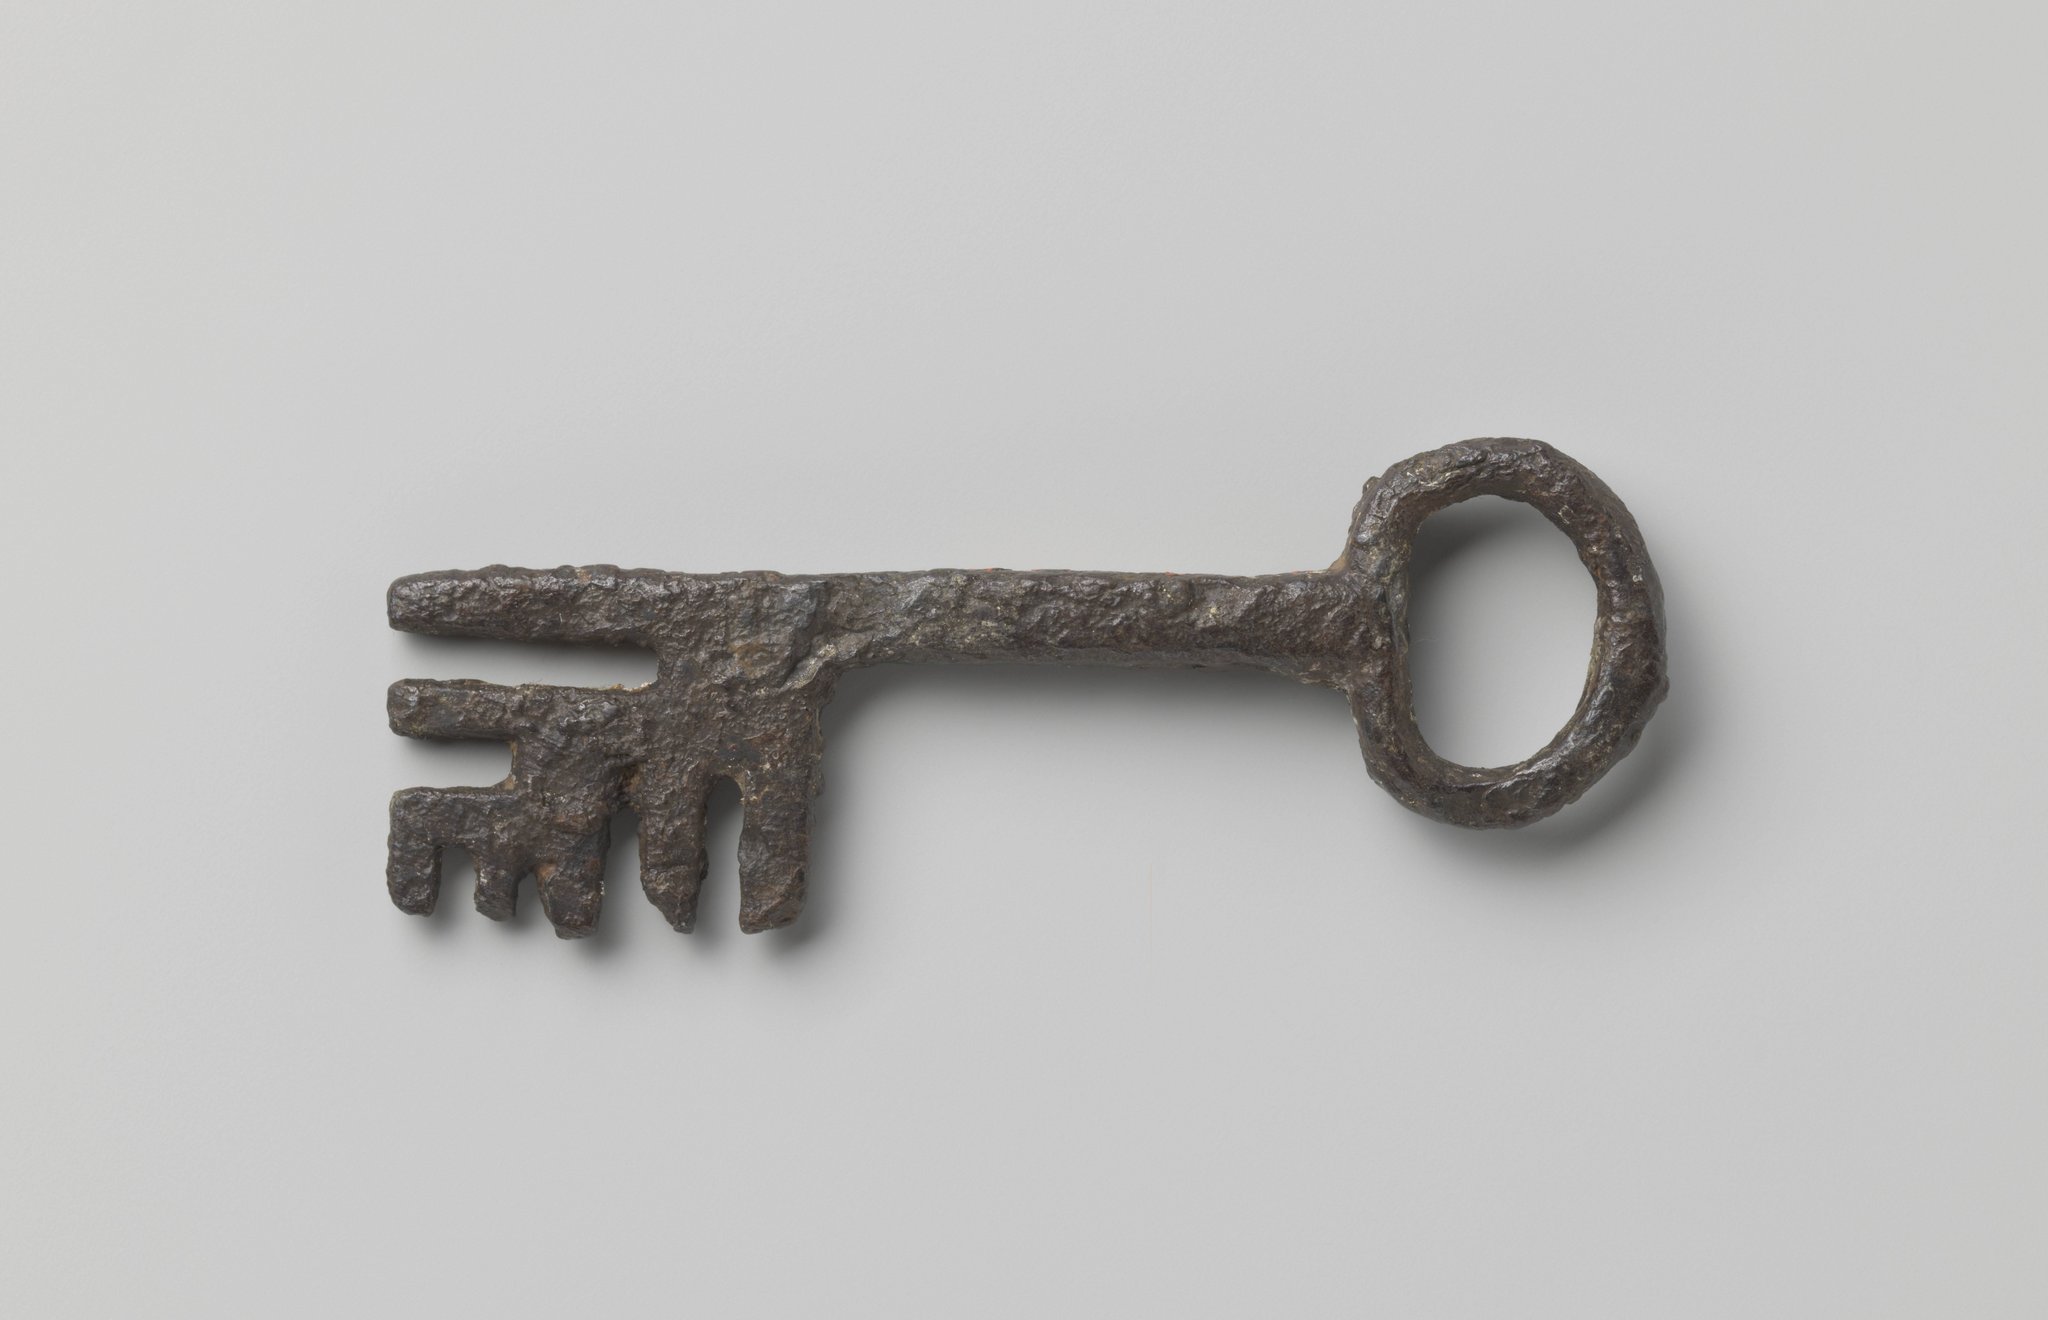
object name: key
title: Sleutel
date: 1500-1600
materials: iron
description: Sleutel met diep ingesneden vierhoekige baard, vierzijdige schacht en ovaal oog.